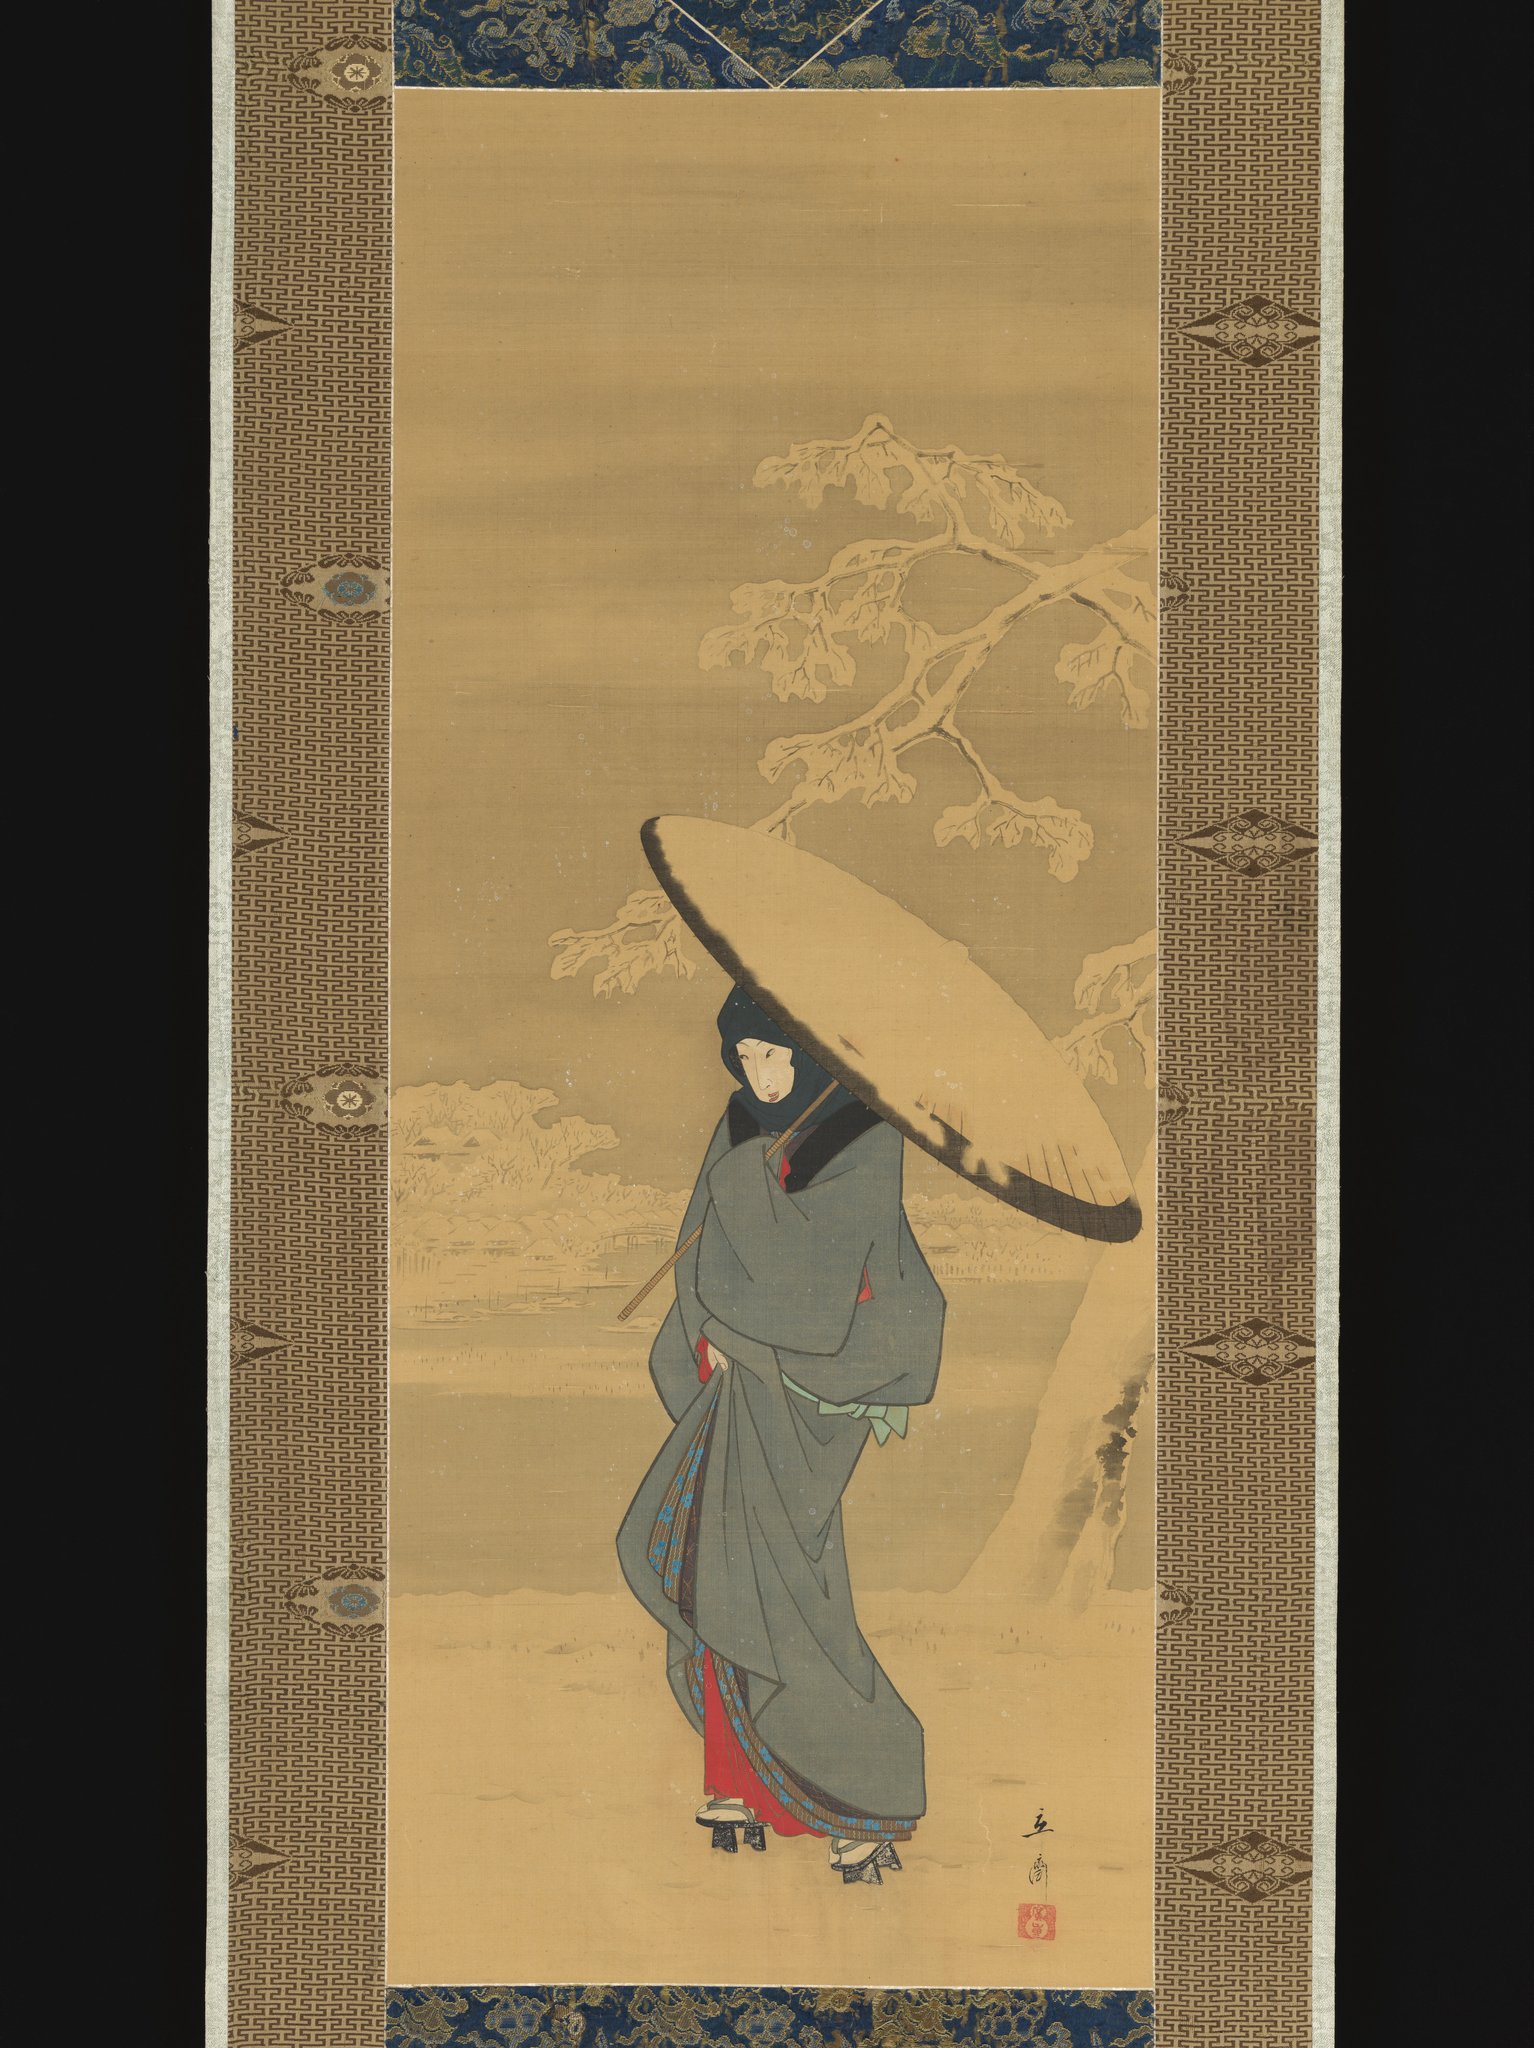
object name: hanging scroll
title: Woman Walking in the Snow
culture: japanese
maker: utagawa hiroshige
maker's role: artist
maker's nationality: japanese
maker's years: 1797-1858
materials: ink, silk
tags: women,snow,umbrellas